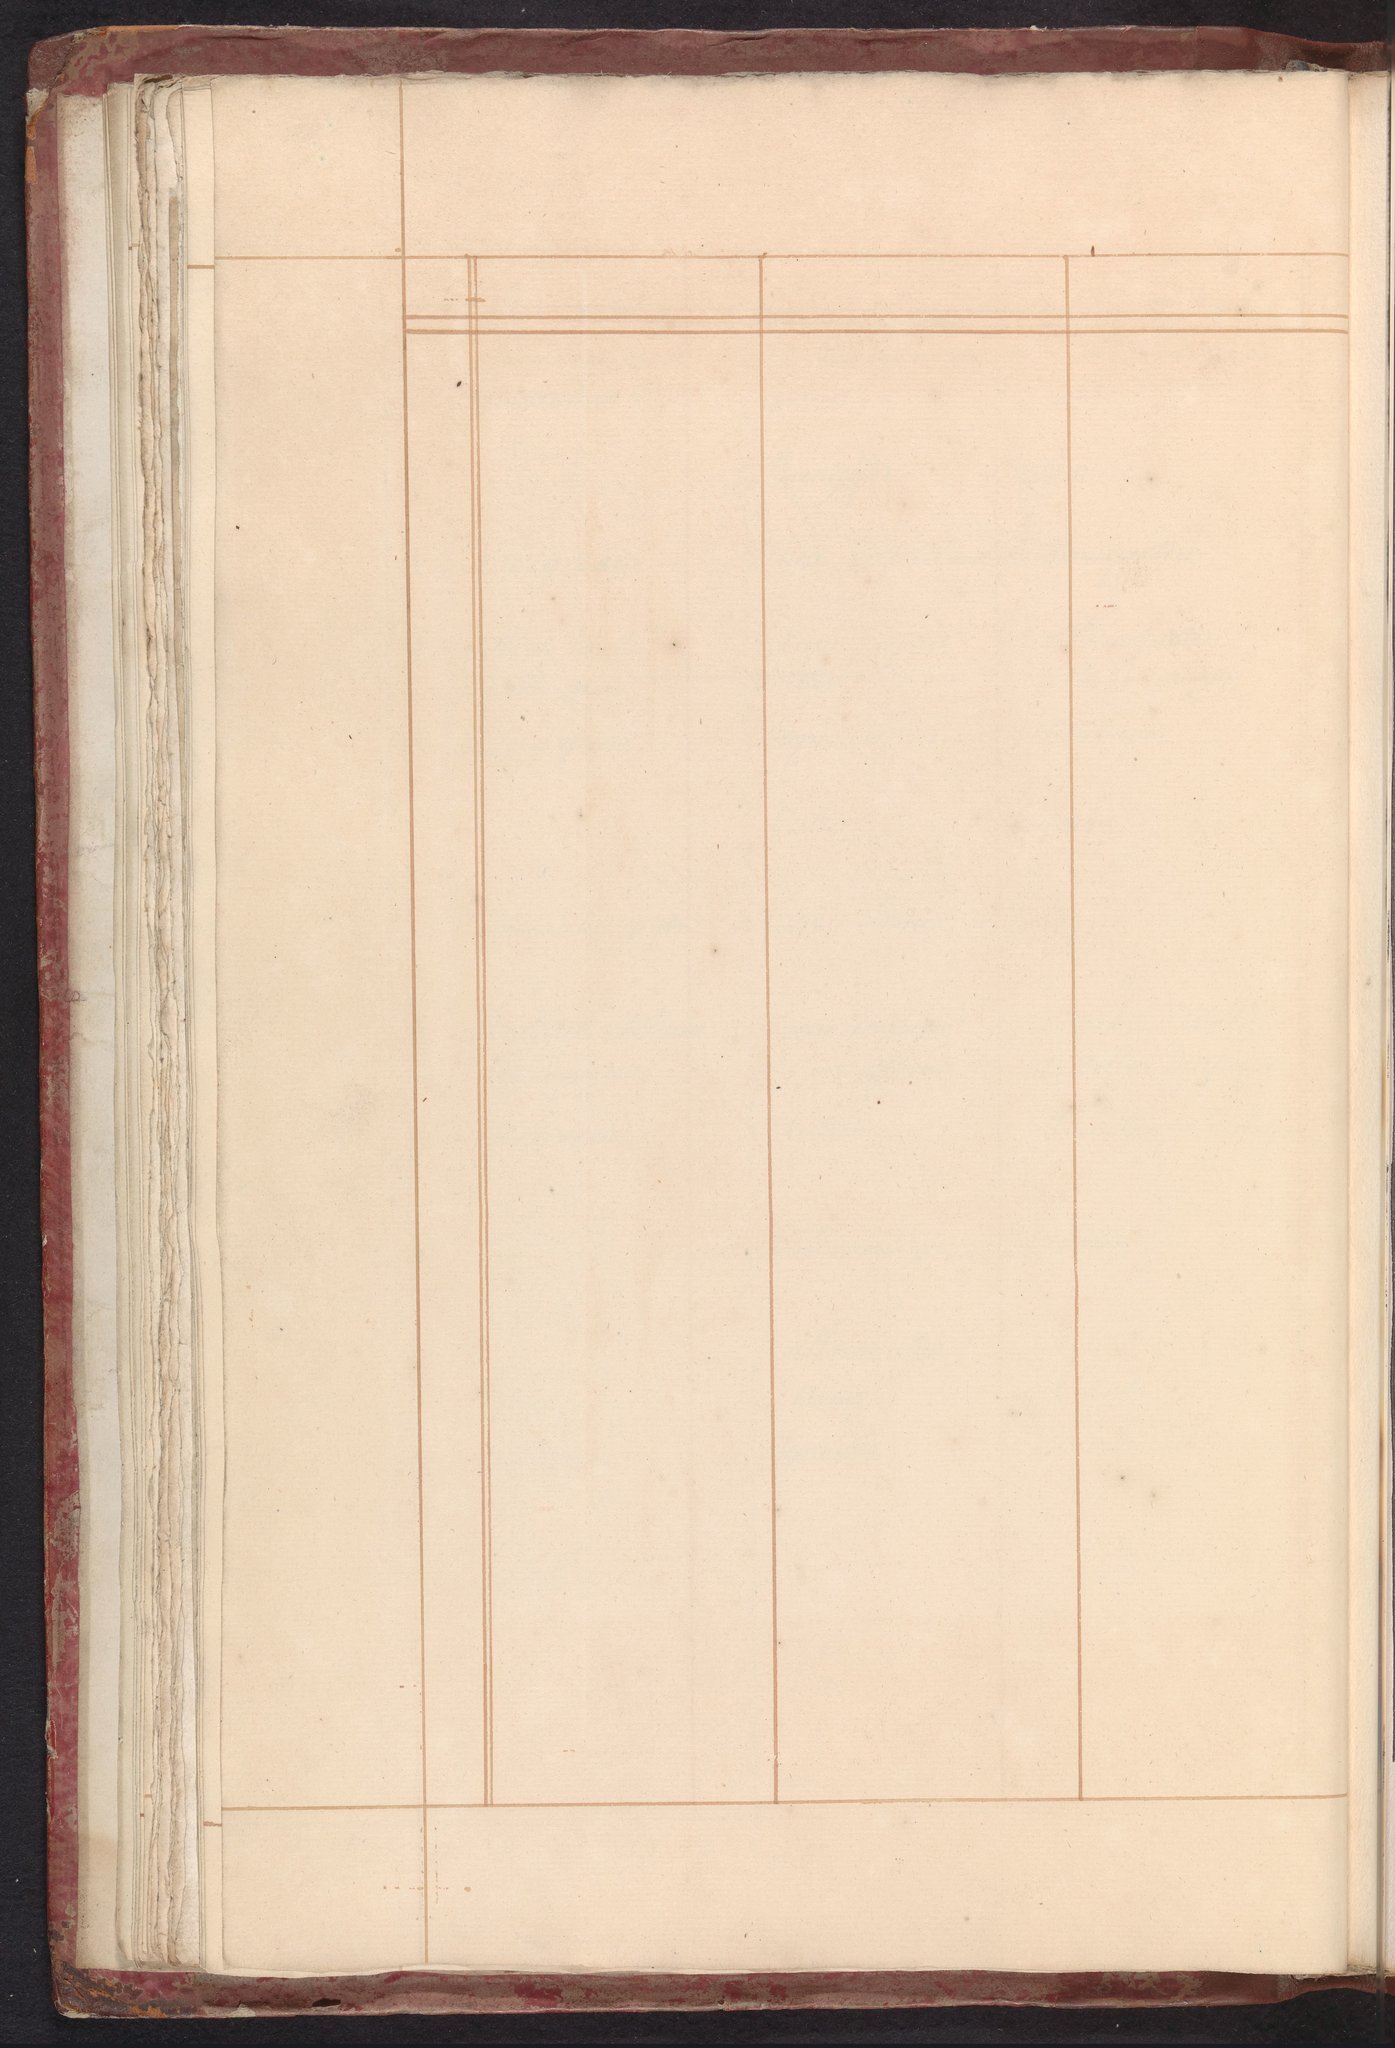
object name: manuscript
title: Oningevuld schema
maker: joseph van huerne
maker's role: kunstliefhebber, mecenas, verzamelaar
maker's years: 1752-1844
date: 1809-1814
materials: ink, paper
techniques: pen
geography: bruges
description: Oningevuld schema met drie kolommen. Onderdeel van het tweede album met tekeningen van viervoeters. Tweede van twaalf albums met tekeningen van dieren, vogels en planten bekend rond 1600, gemaakt in opdracht van keizer Rudolf II. Met toelichting in Nederlands, Latijn en Frans.